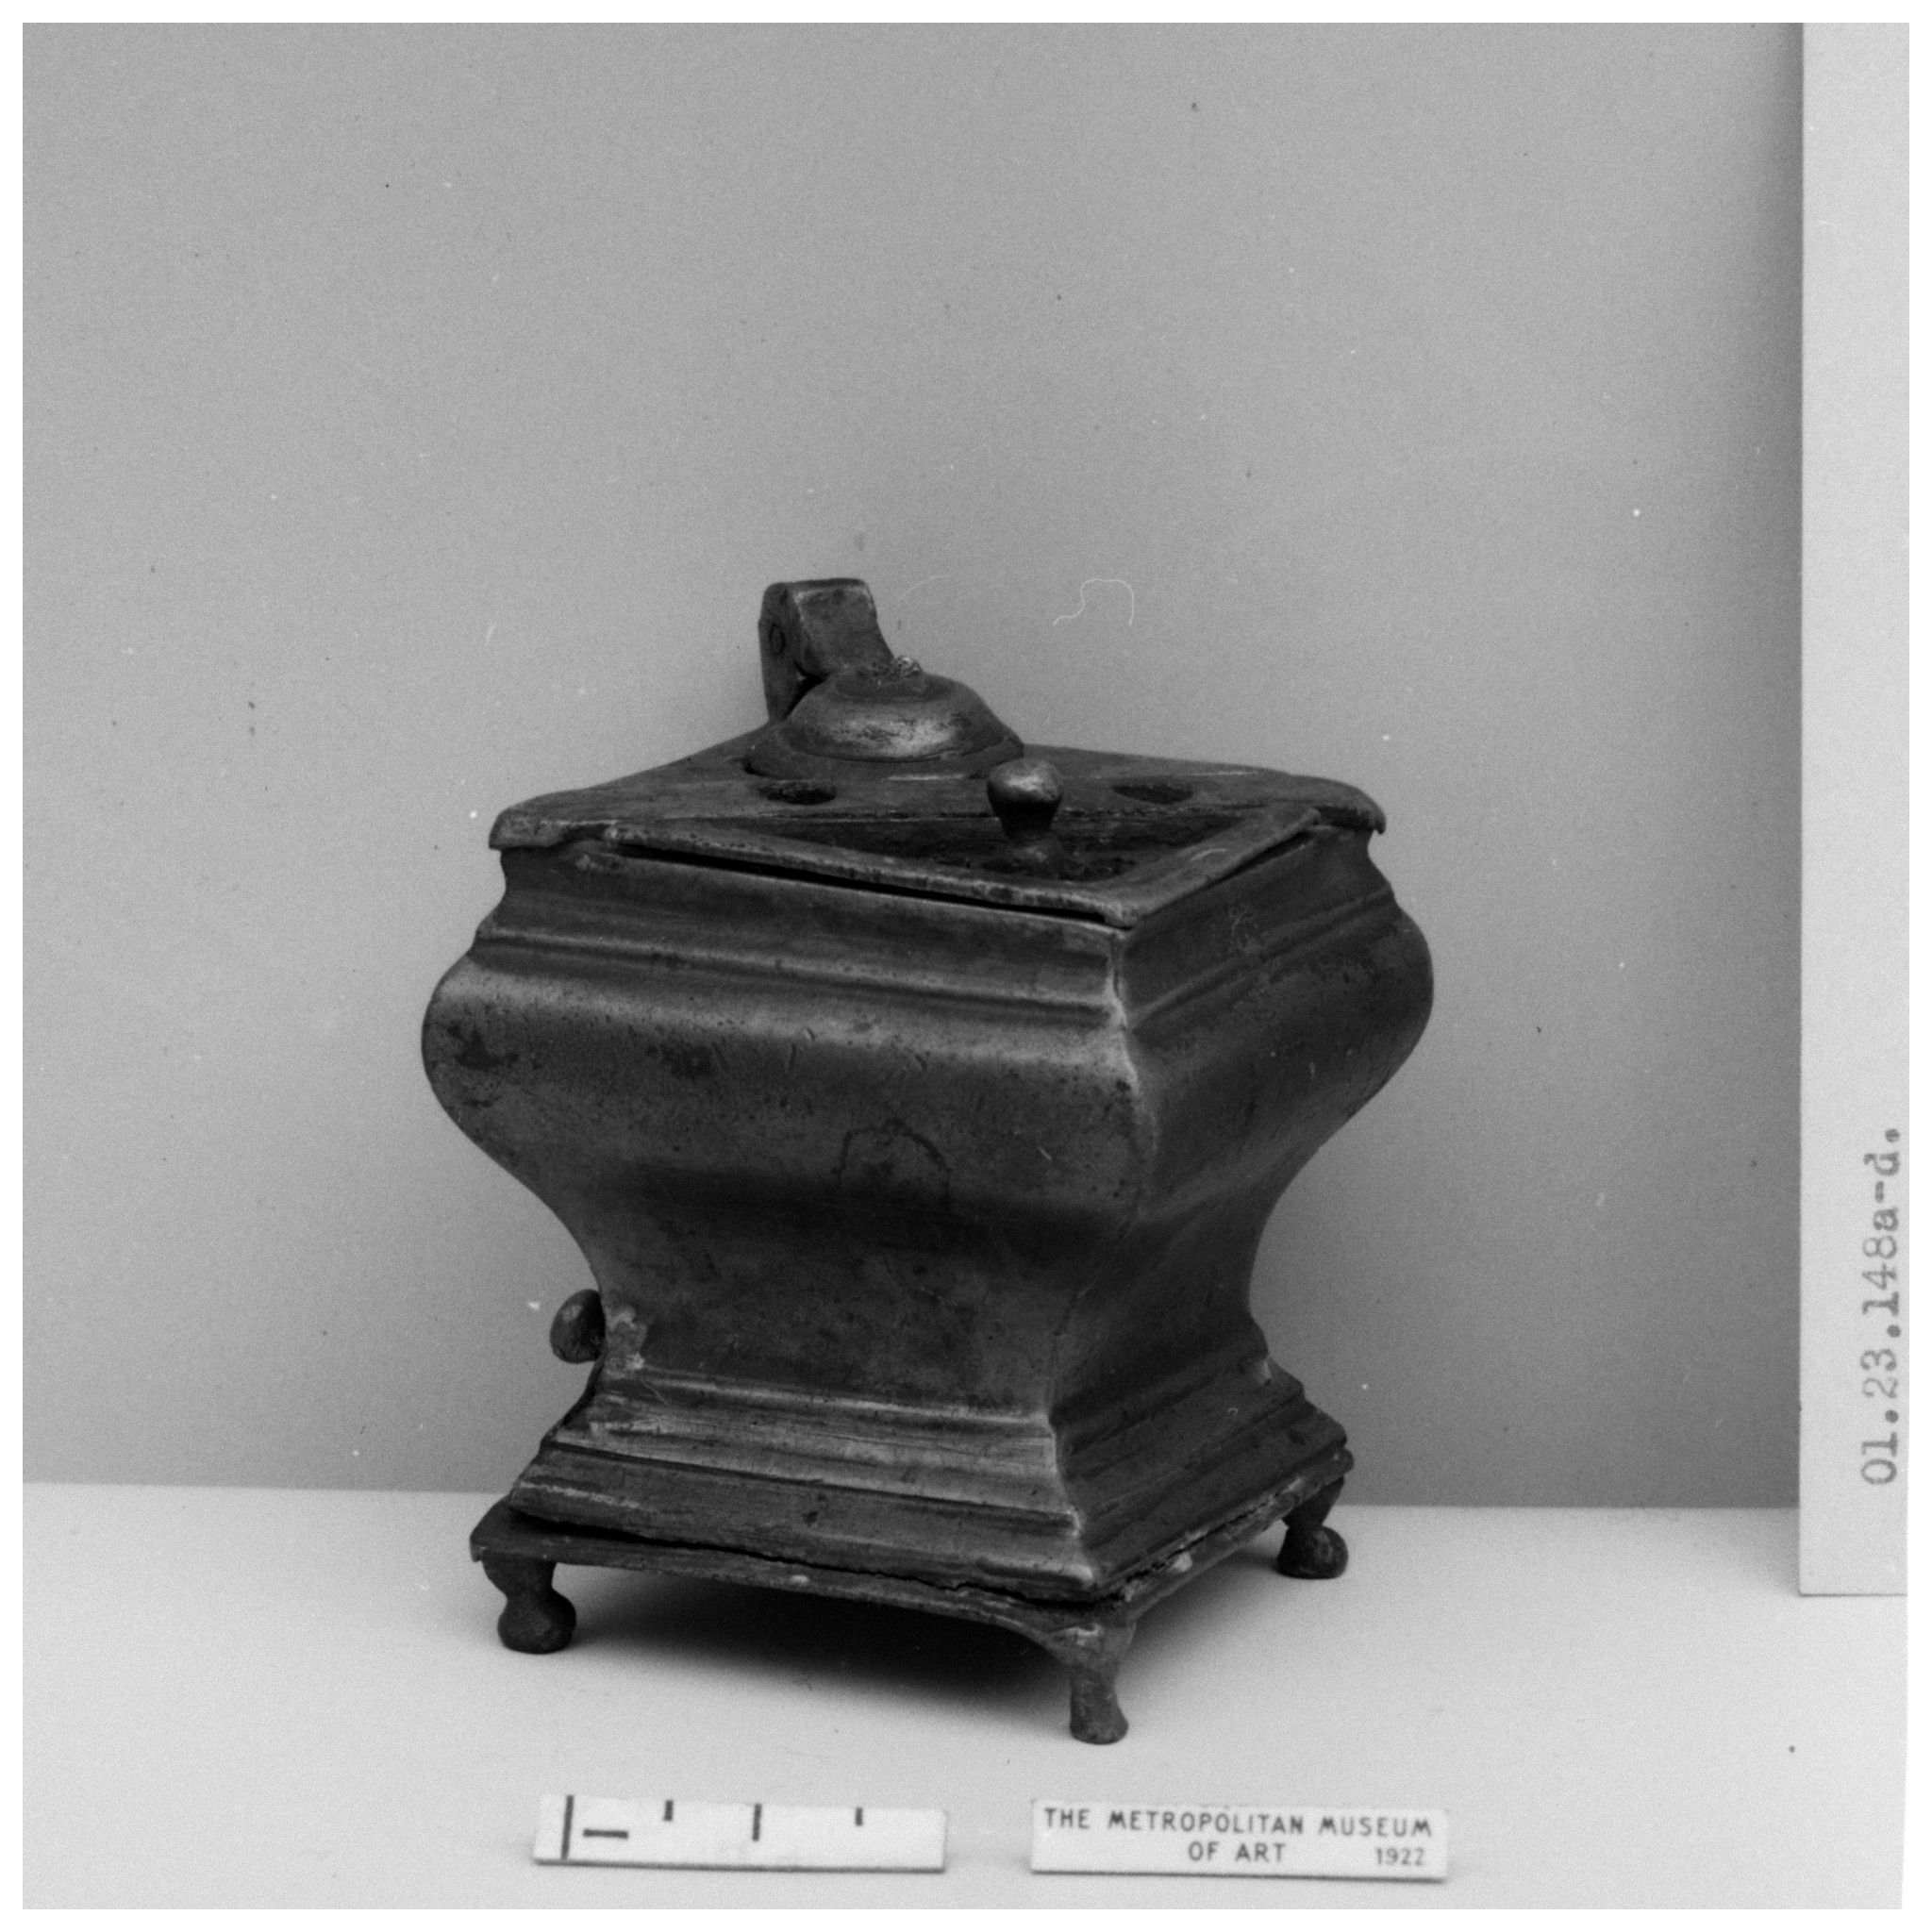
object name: inkstand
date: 1601-1800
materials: pewter